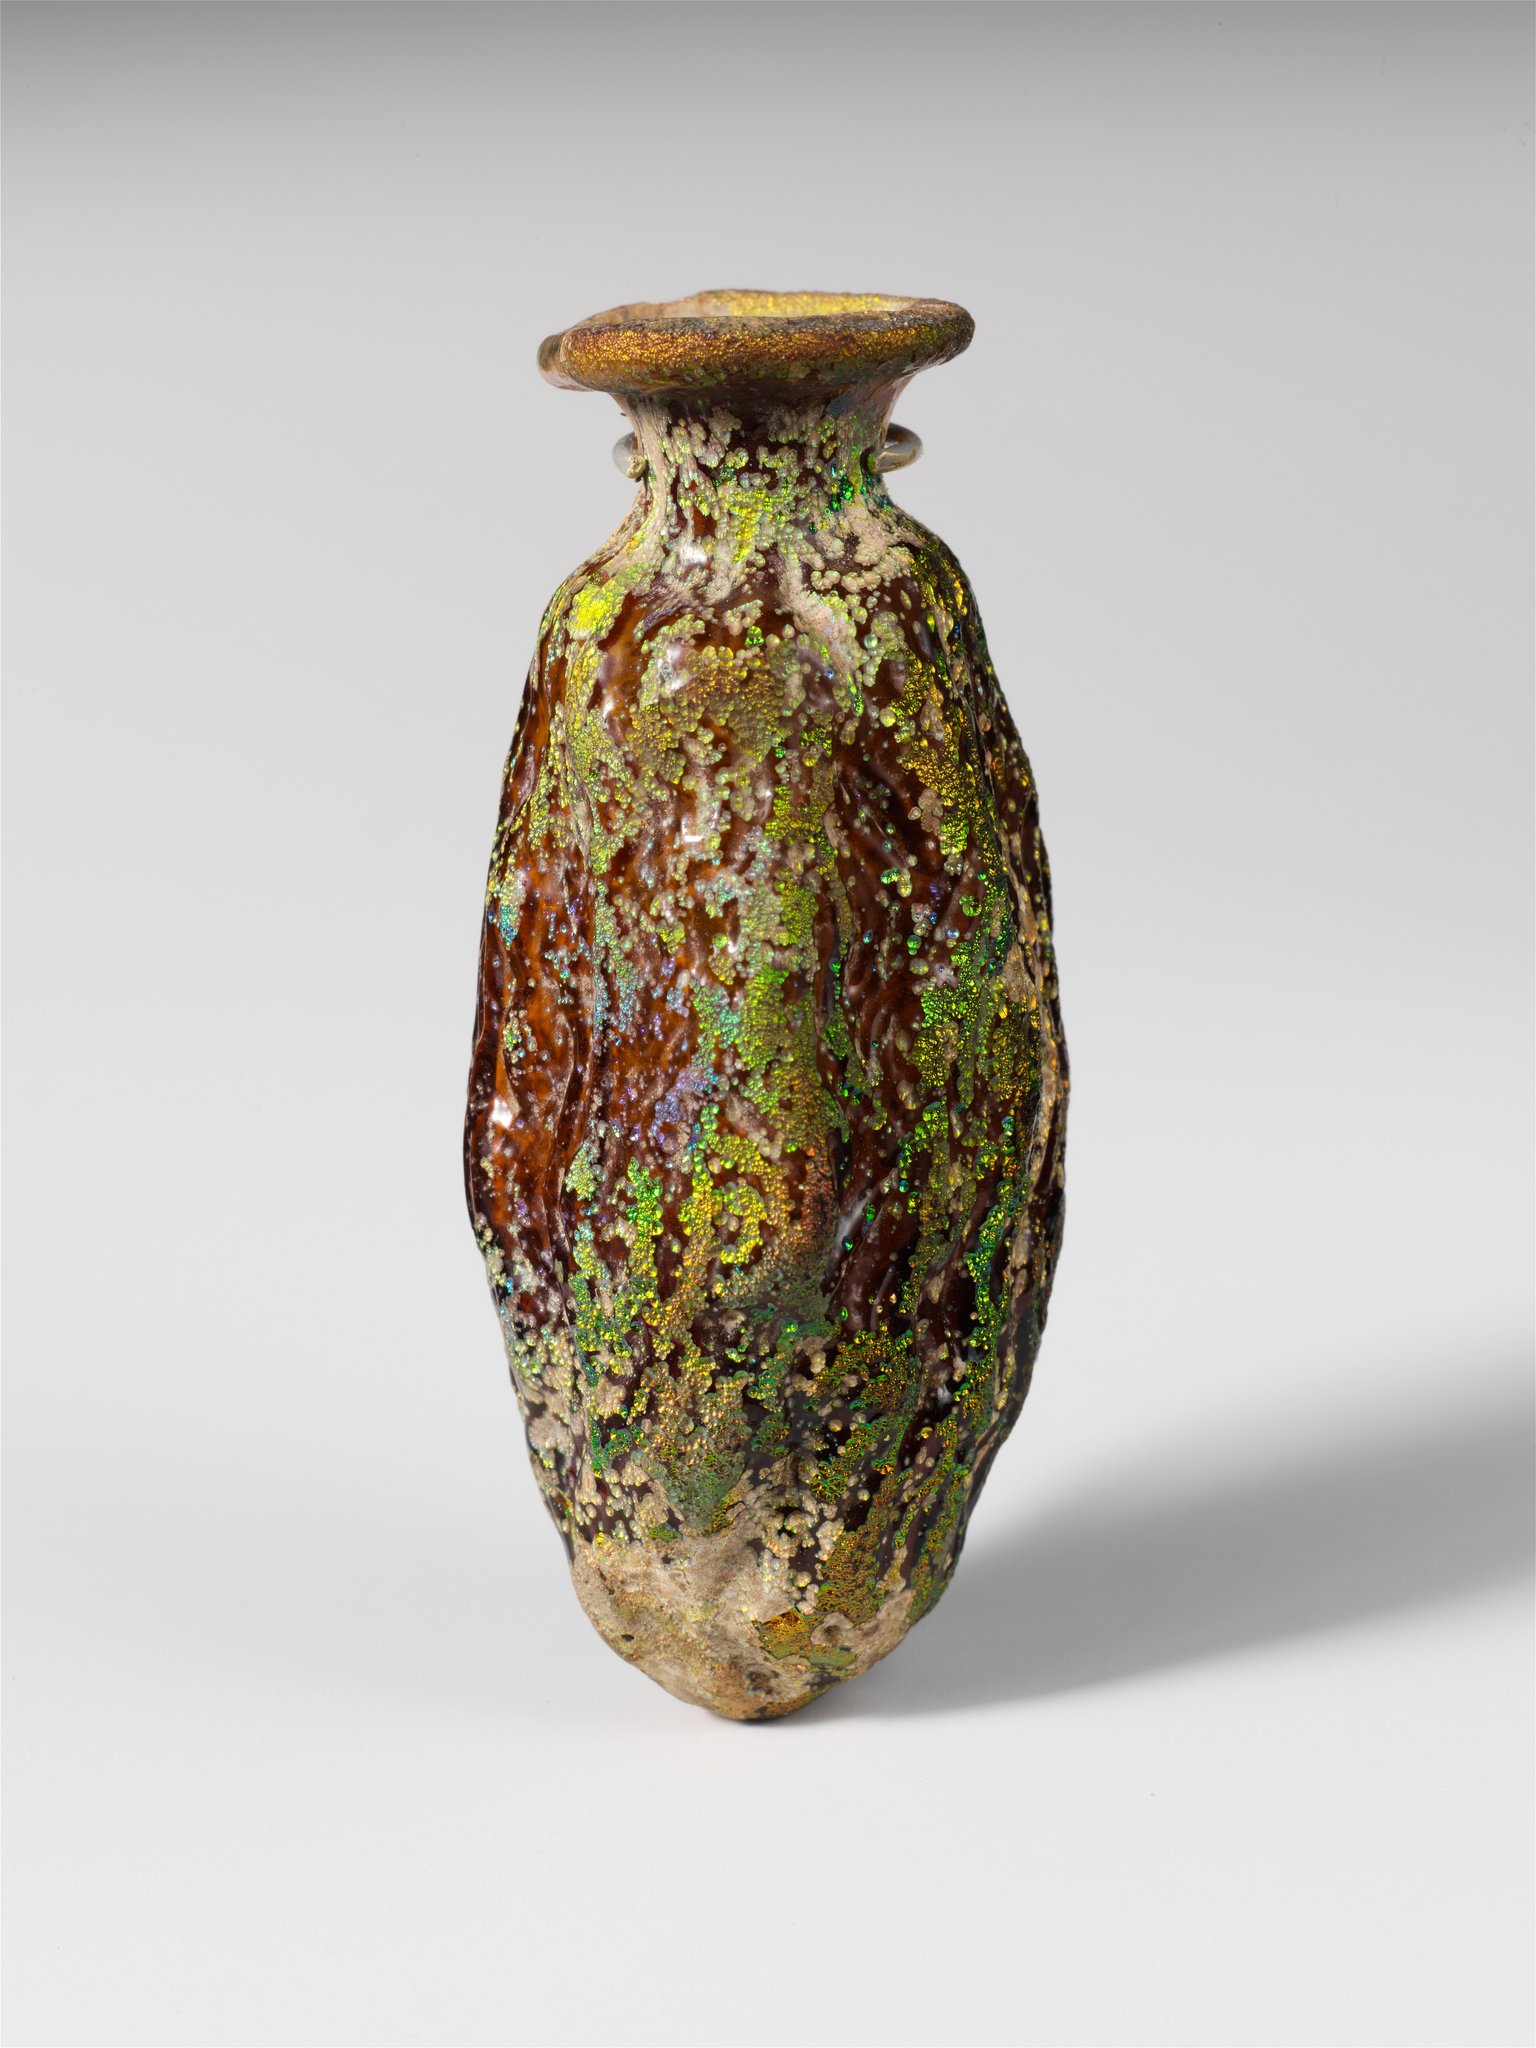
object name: flask in the form of a date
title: Glass bottle shaped like a date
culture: roman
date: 34-133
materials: glass